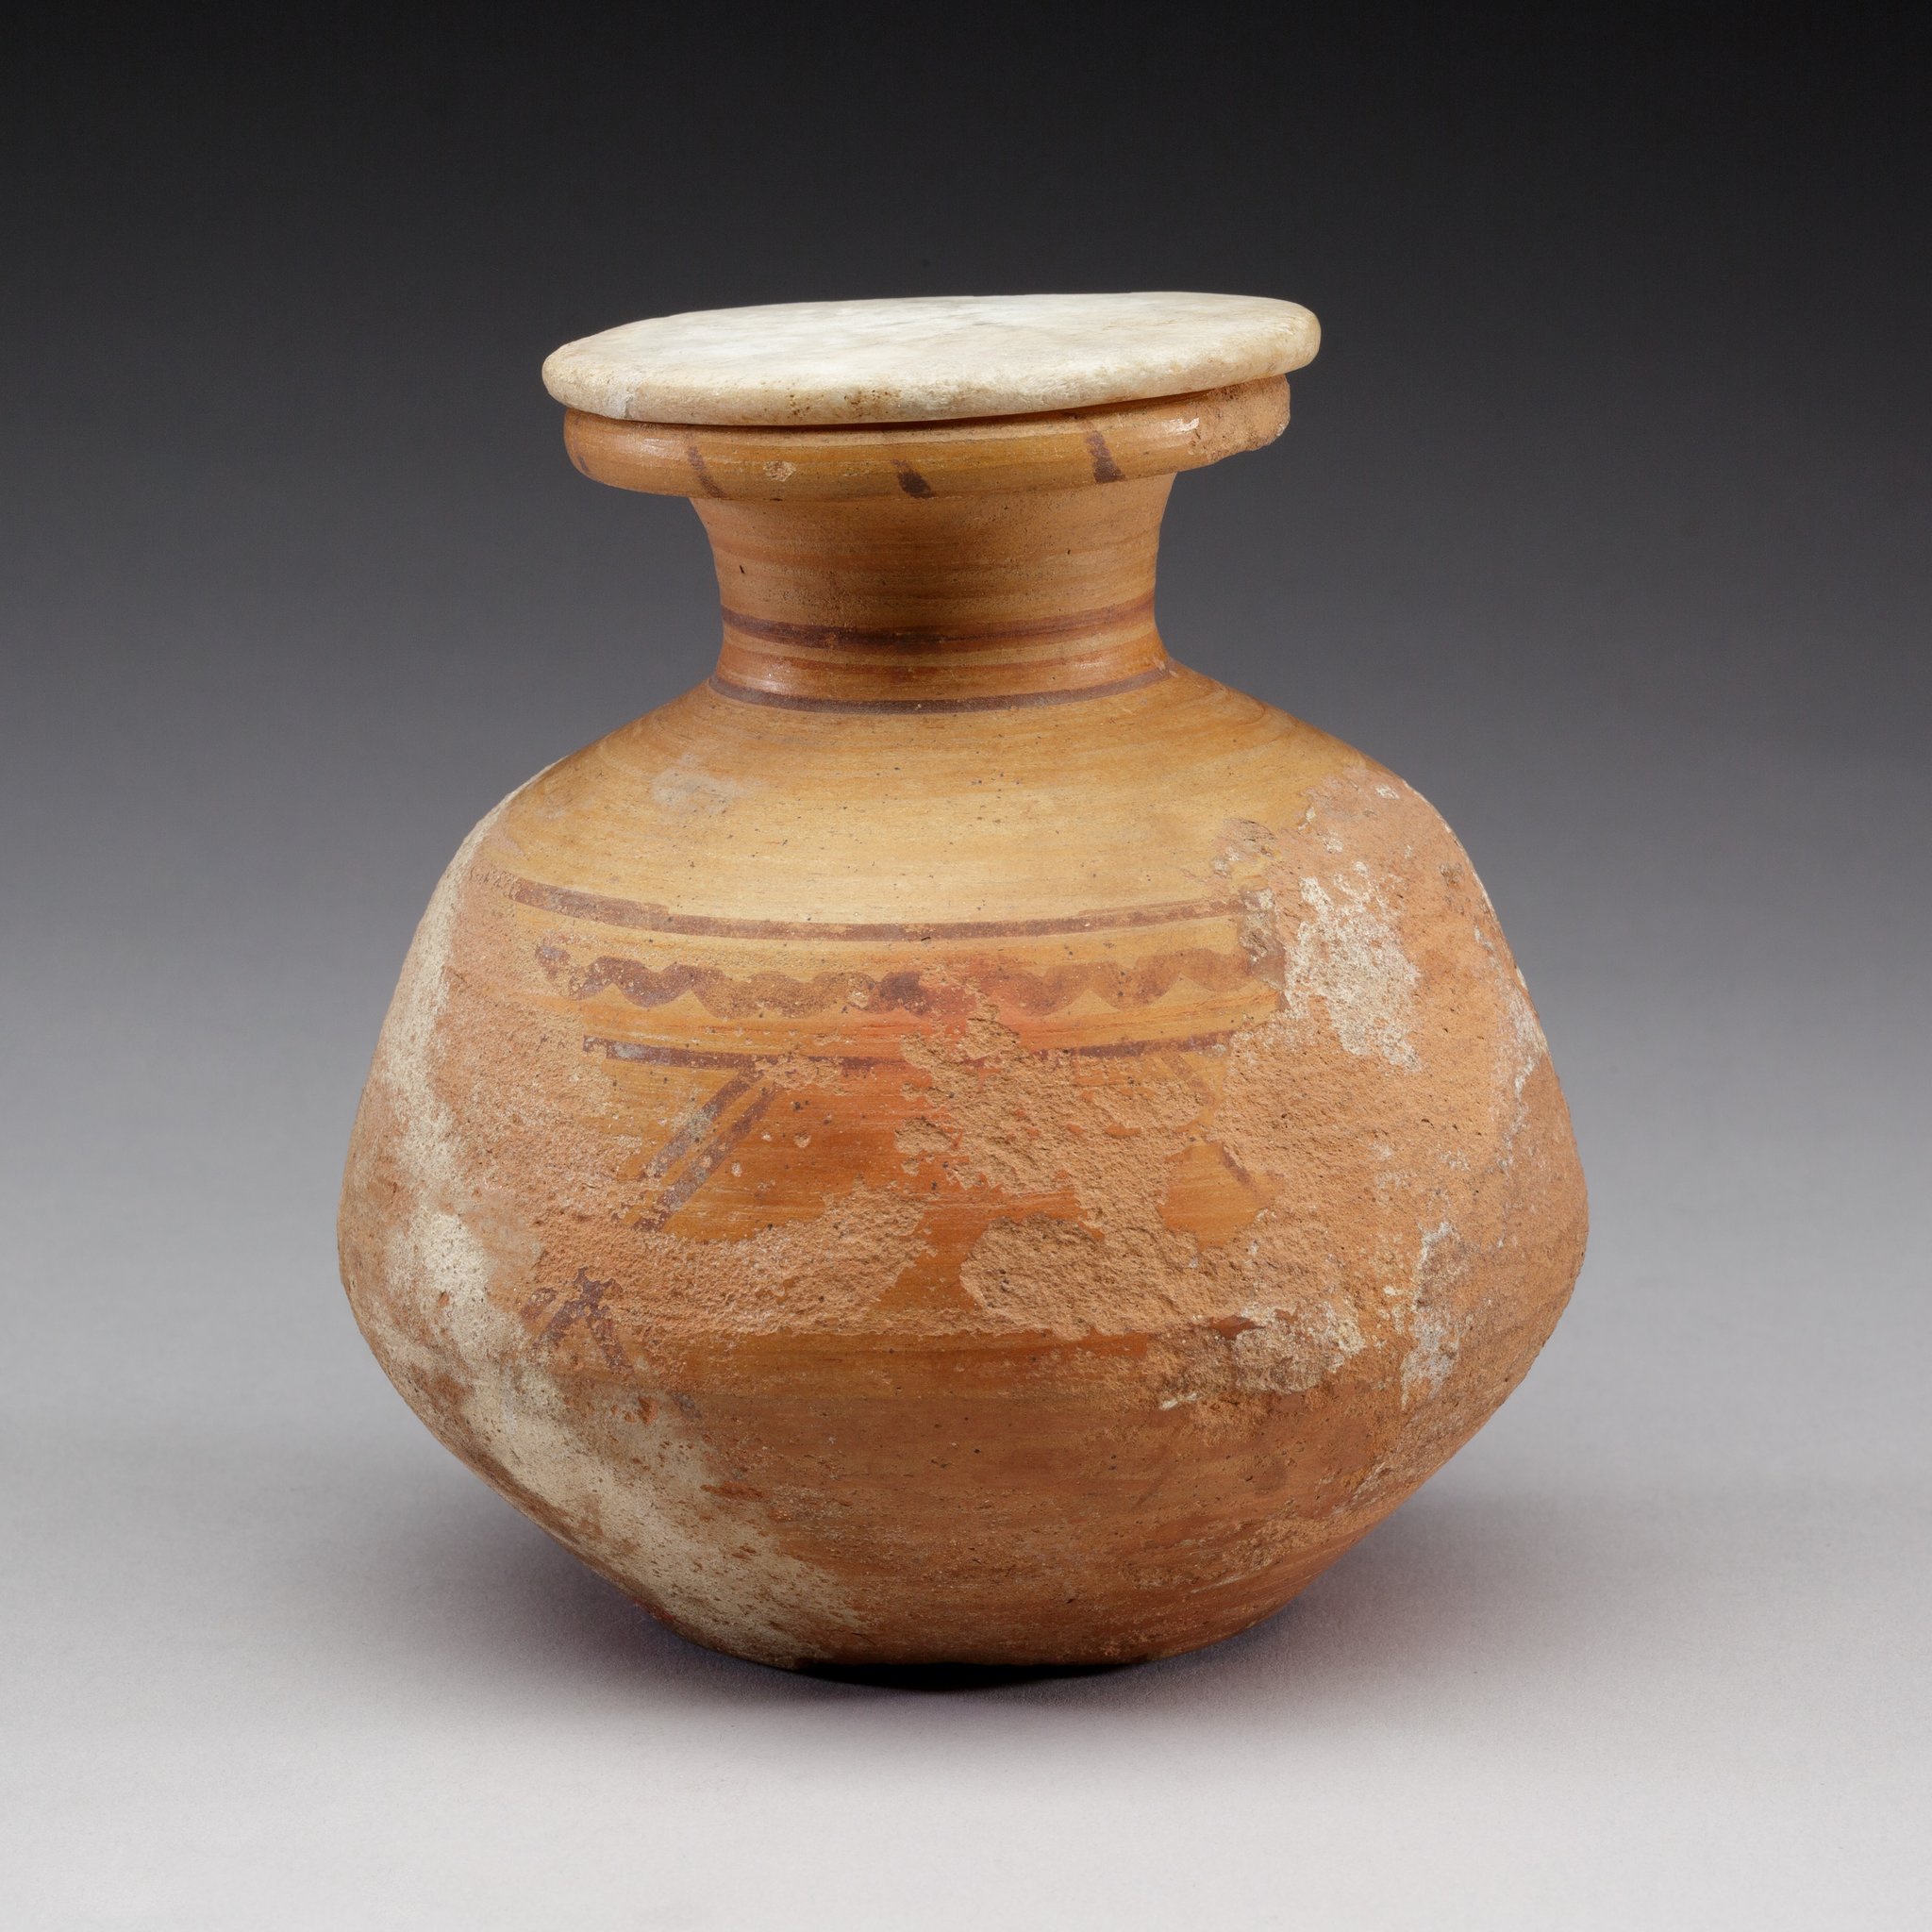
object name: jar, neferkhawet, ruiu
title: Jar from Neferkhawet's Tomb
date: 1504-1447 BCE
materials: paint, pottery, stone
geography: egypt